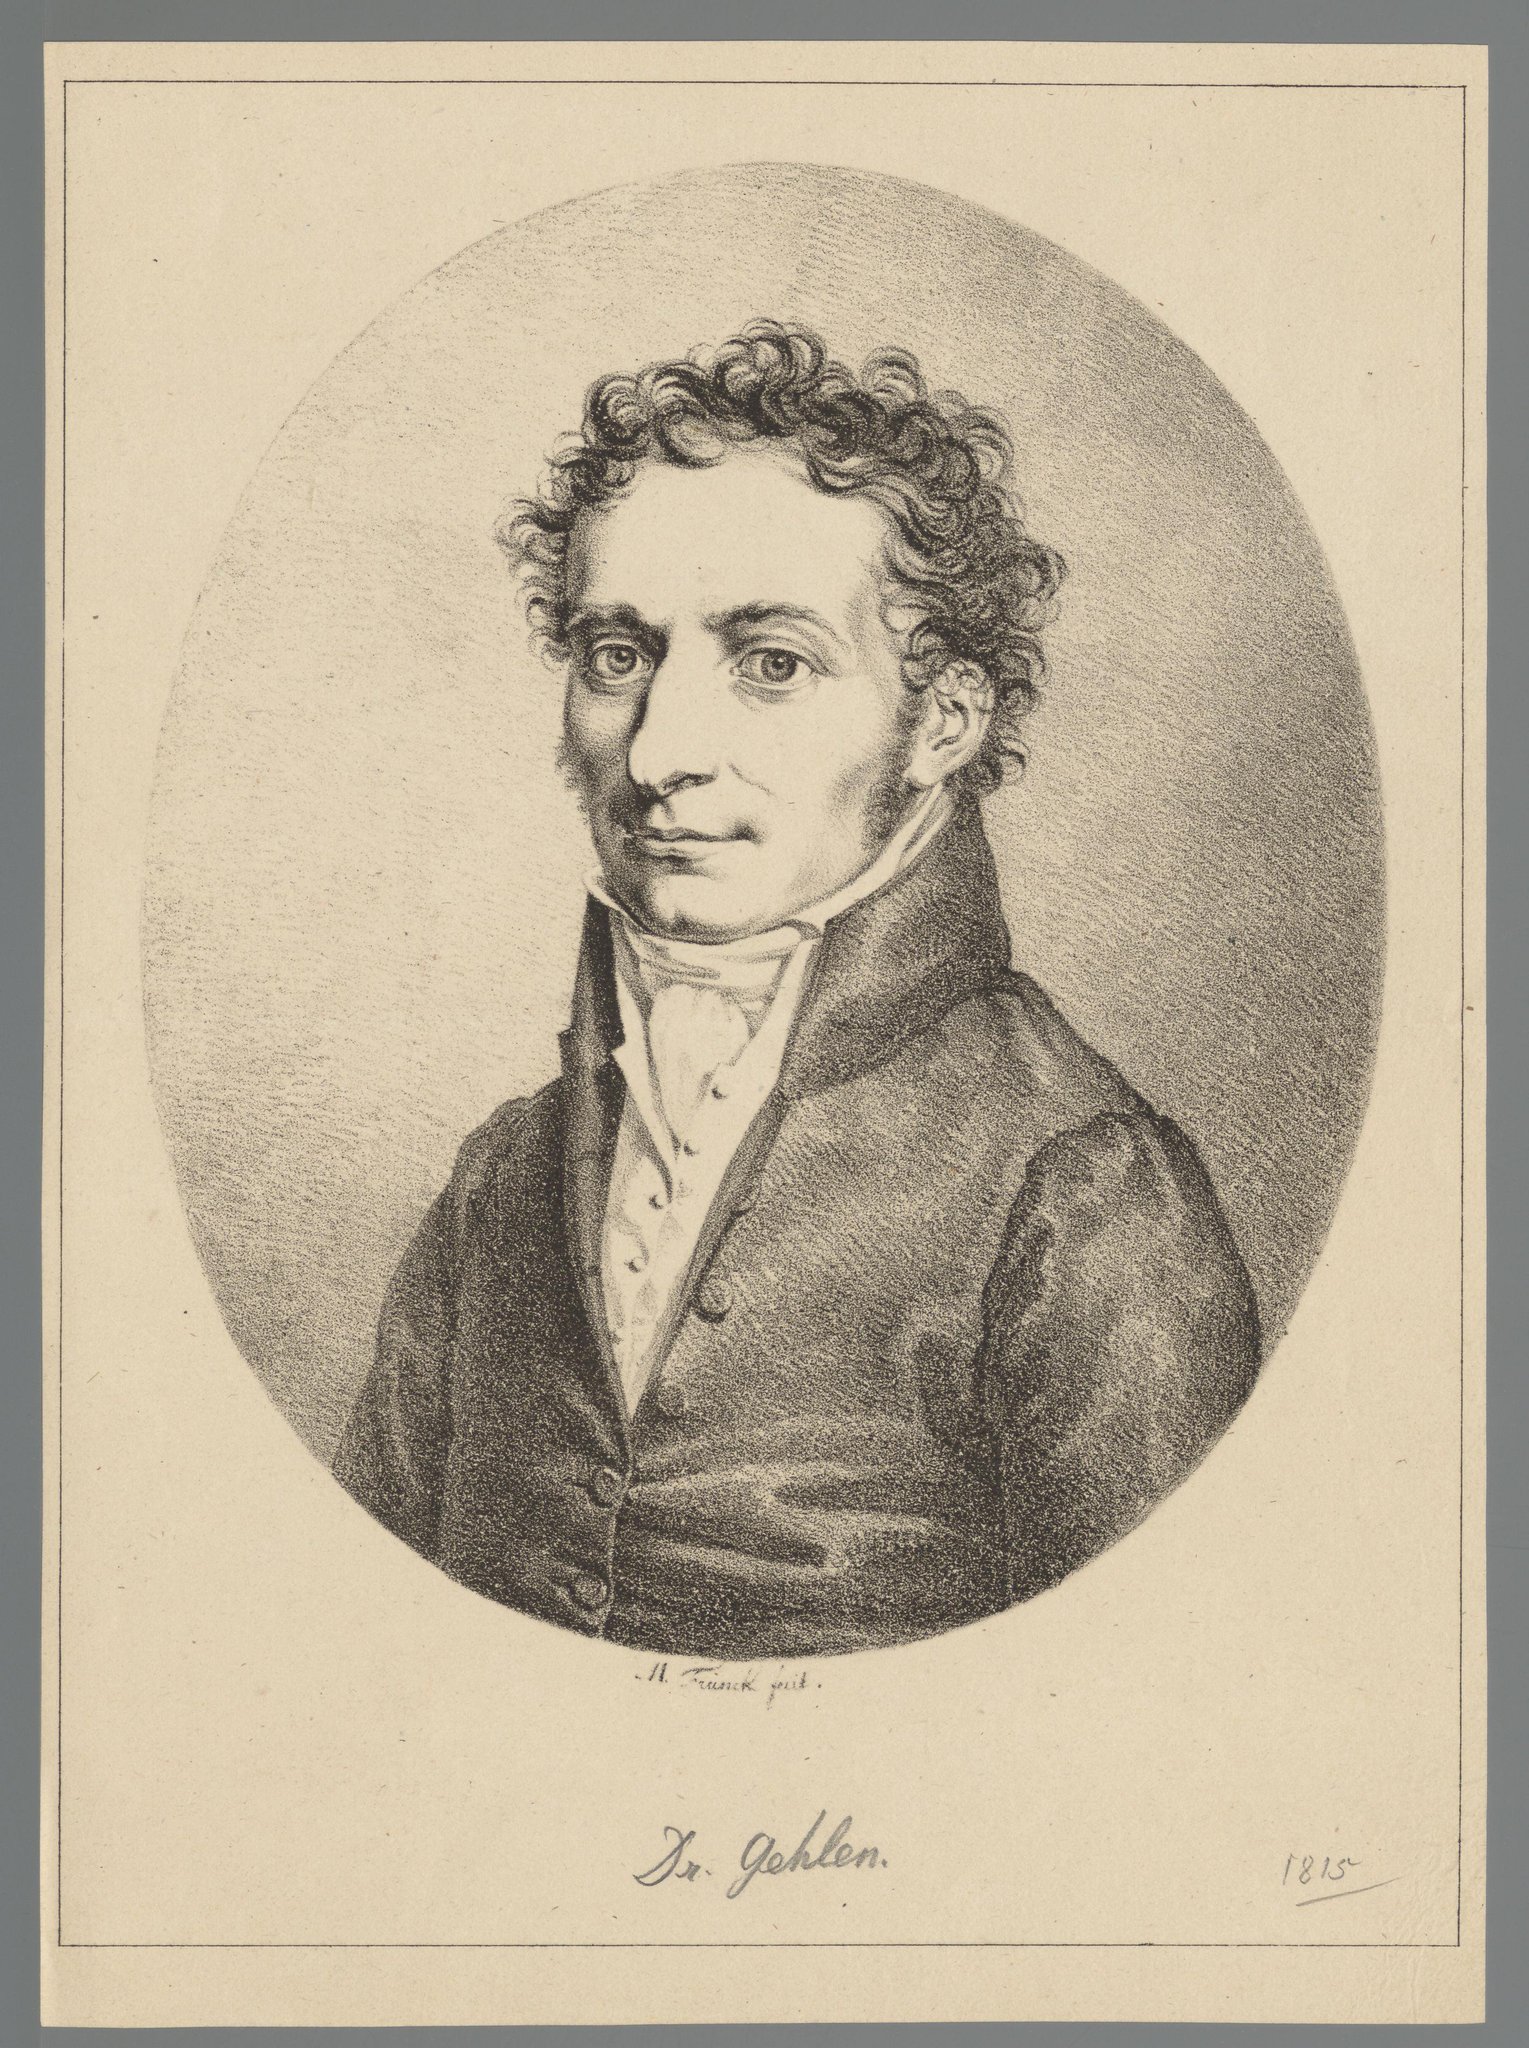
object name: print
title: Portret van Adolph Ferdinand Gehlen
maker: maximilian franck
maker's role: print maker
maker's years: 1780-1830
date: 1805-1815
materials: paper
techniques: lithograph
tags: historical persons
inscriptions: number: ‘1815’, collector's mark: Lugt 2228